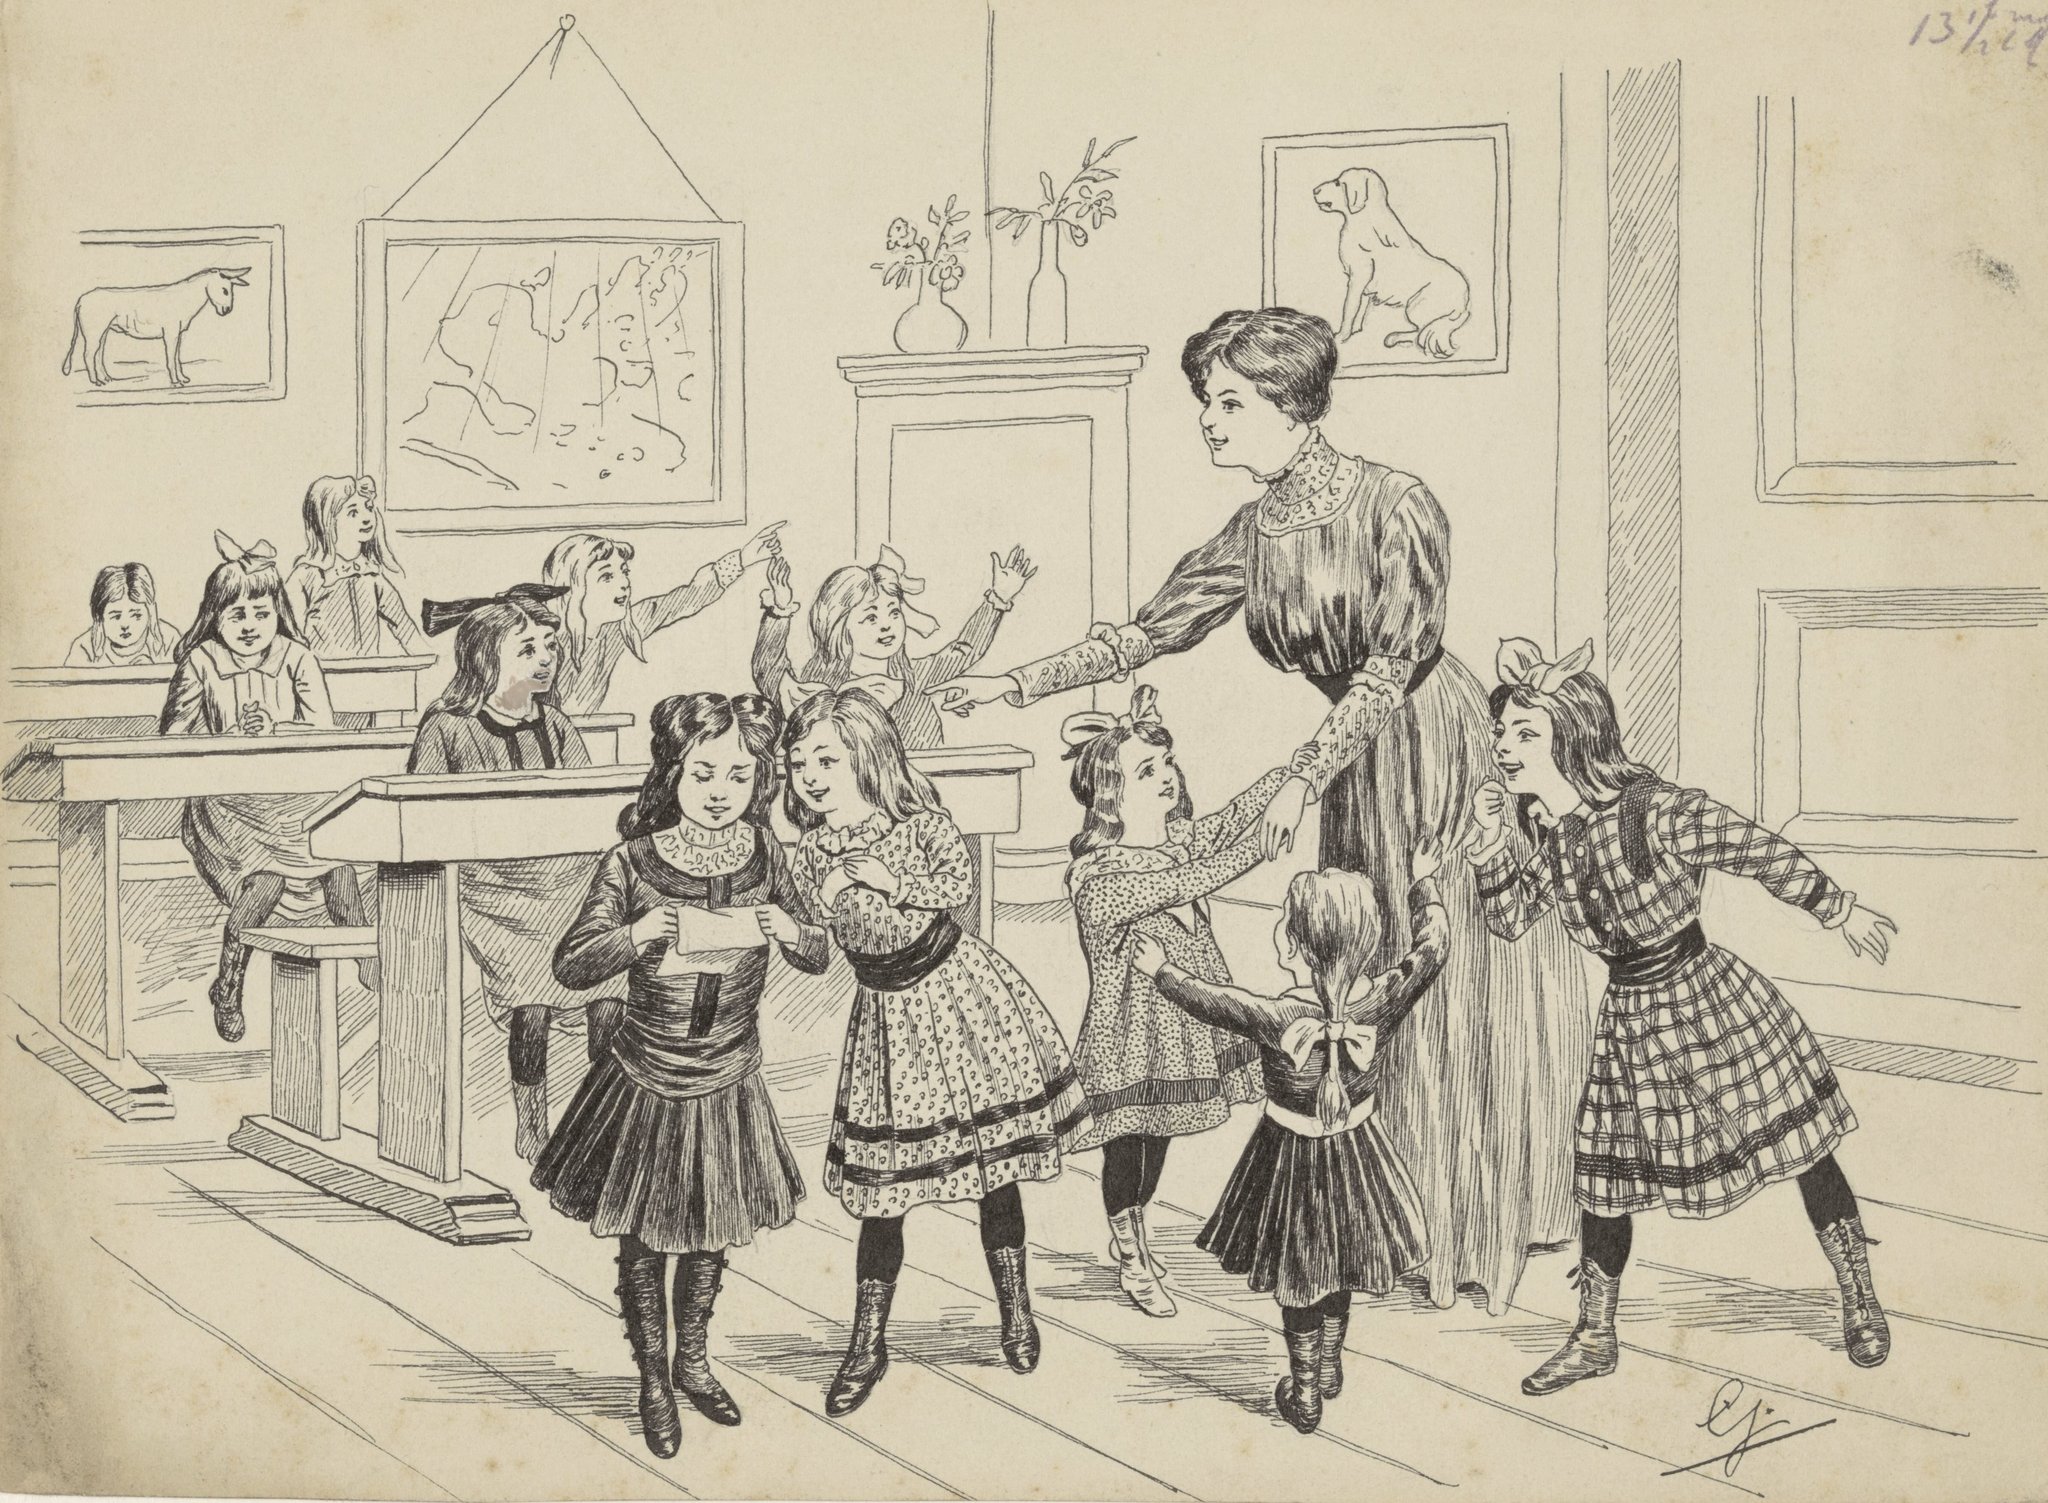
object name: drawing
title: Schoolklas met meisjes en een onderwijzeres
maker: johan georg gerstenhauer zimmerman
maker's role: draughtsman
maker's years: 1858-1931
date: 1868-1931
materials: ink, paper, pencil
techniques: pen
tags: reading, girl (child between toddler and youth), elementary school; class, form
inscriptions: collector's mark: Lugt 2228a, :, signature: ‘G.’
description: In een lokaal staat een onderwijzeres voor de klas. Om haar heen staan vijf meisjes. Twee van de meisjes lezen iets van een vel papier. Op de achtergrond zitten zes meisjes in de schoolbanken. Aan de muur hangen schilderijen van een hond en ezel en een kaart.